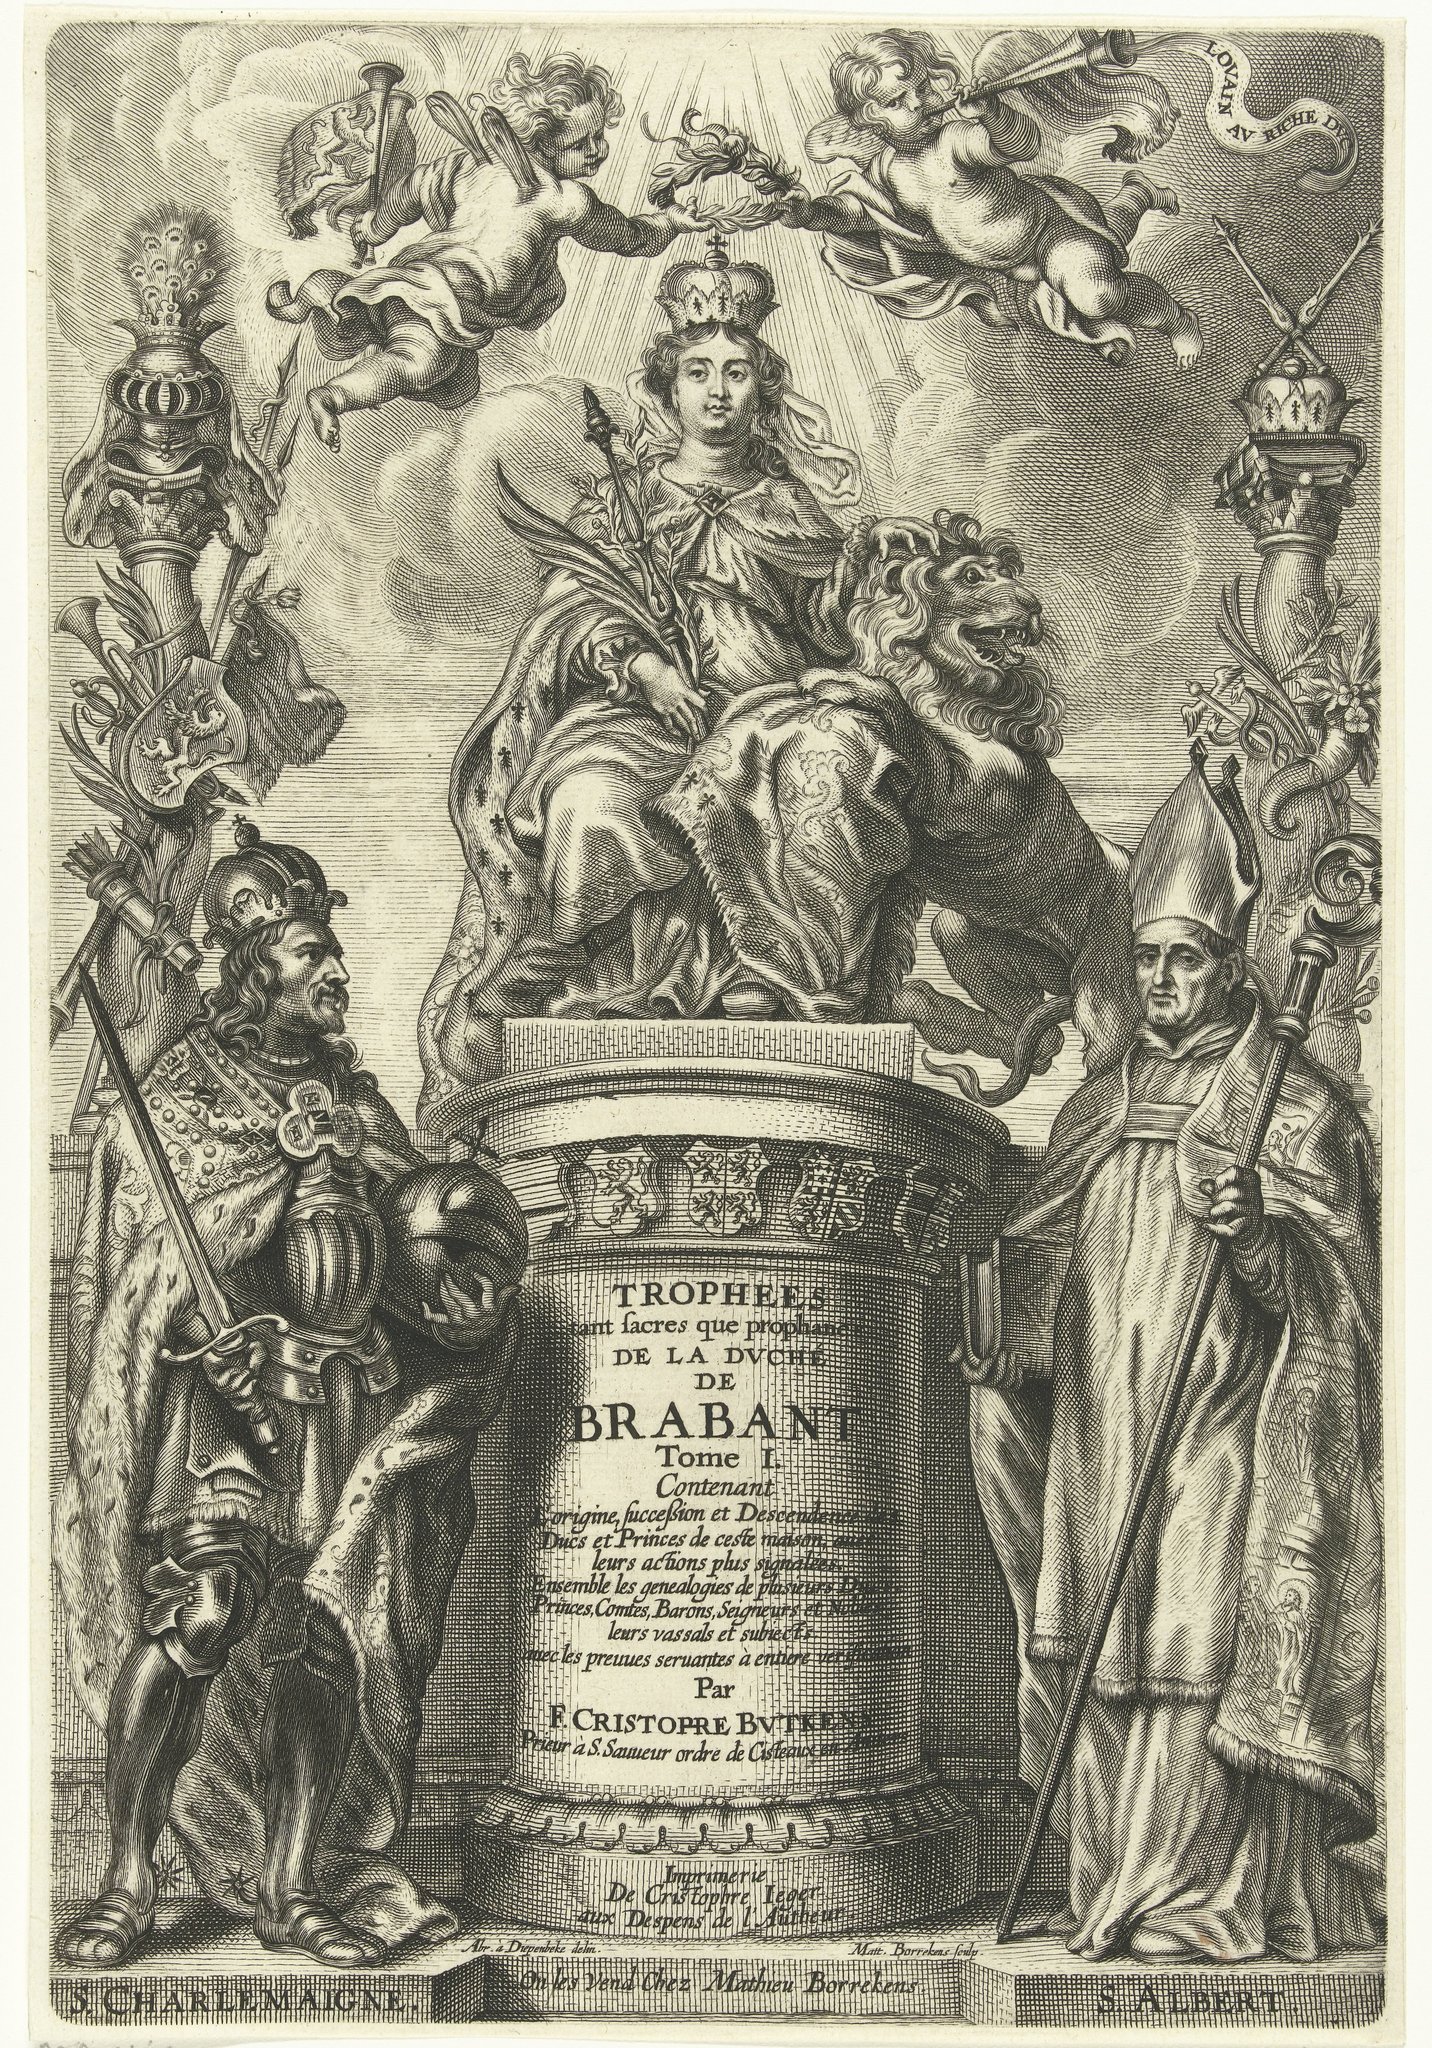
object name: titelblad, titelpagina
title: Titelpagina voor: Christophorus Butkens, Trophees tant sacres que prophanes de la duché de Brabant, 1641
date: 1641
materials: paper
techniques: engraving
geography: antwerp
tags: 'cornucopia', horn of plenty, saints, caduceus (staff with two snakes, attribute of mercury), beasts of prey, predatory animals: lion, the holy roman emperor charlemagne; possible attributes: crown, model of church, orb, sceptre, sword, cupids: 'amores', 'amoretti', 'putti', brabant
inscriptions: collector's mark: Lugt 1838, collector's mark: Lugt 240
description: Op een troon zit de vrouwelijke personificatie van Brabant met een scepter in haar handen en de leeuw naast haar, het heraldisch dier van het hertogdom Brabant. Ze wordt met een lauwerkrans gekroond door twee vliegende putti. Een van de putti heeft de Brabantse vlag vast, de andere blaast een hoorn waaruit een banderol komt. Links naast de troon staat Karel de Grote, in wapenrusting en met zwaard en wereldbol in de handen. Rechts naast de troon staat de H. Albert van Leuven, in zijn functie van aartsbisschop van Brabant. Beiden zijn representatief voor de belangrijke wereldlijke en geestelijke leiders die Brabant in haar geschiedenis heeft gehad. Twee pilaren langs de troon. De linker draagt wapens en de rechter de caduceus en de hoorn des overvloeds. Beide staan symbool voor de militaire en wetenschappelijke successen van Brabant. Op de troon staat de Franse titel van het boek.